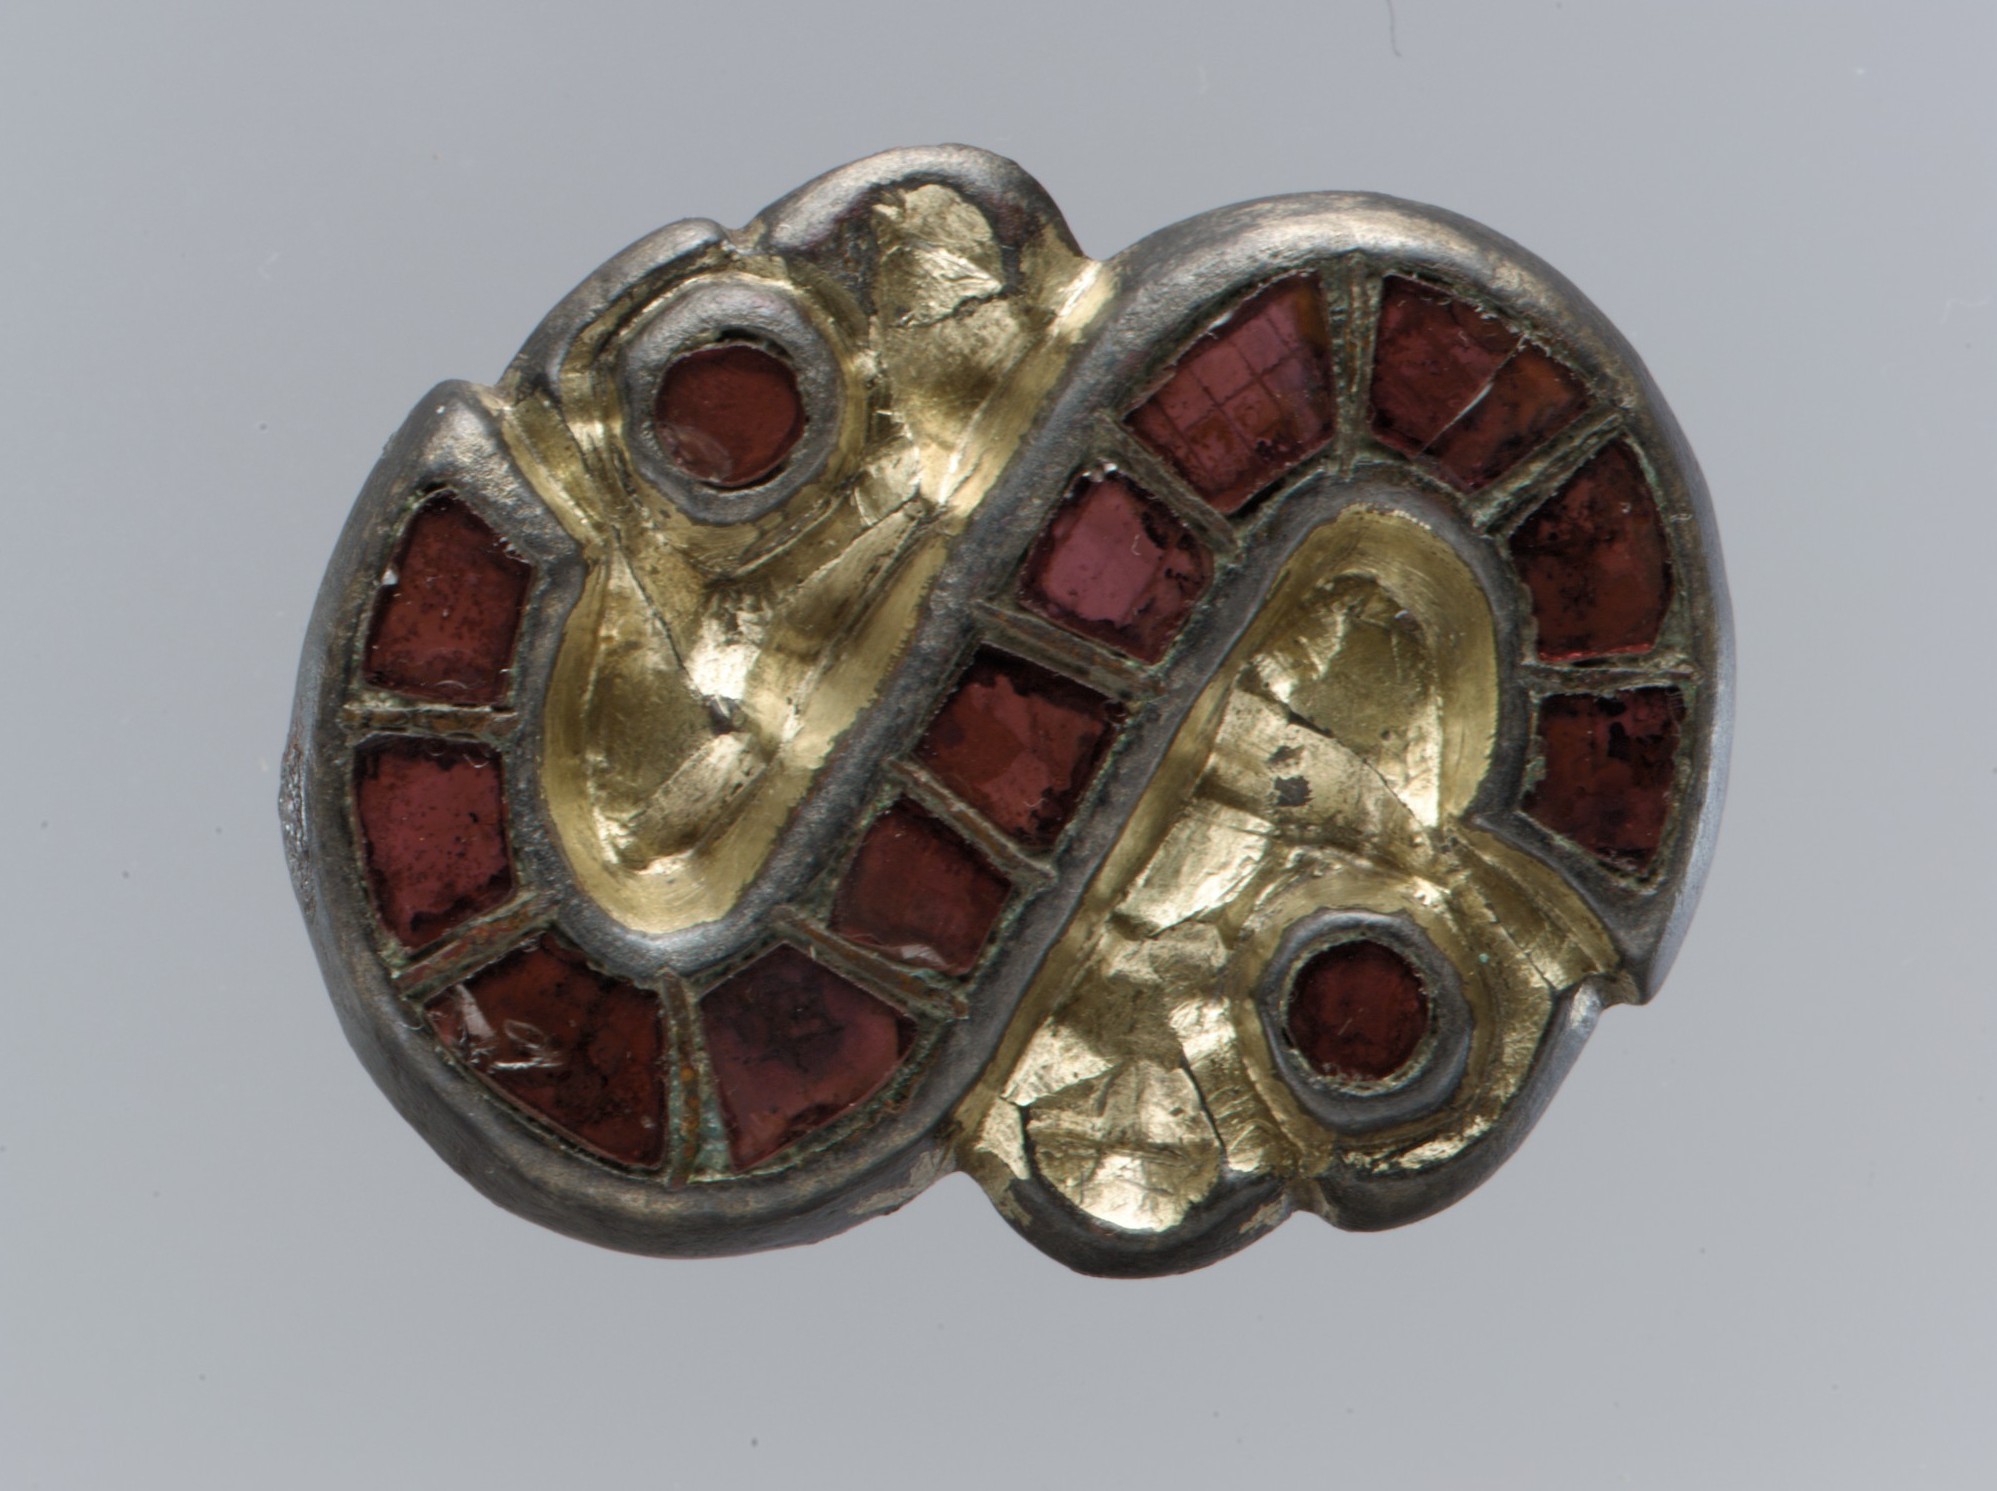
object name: brooch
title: S-Shaped Brooch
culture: langobardic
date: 567-600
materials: foil, garnet, metal, silver gilt